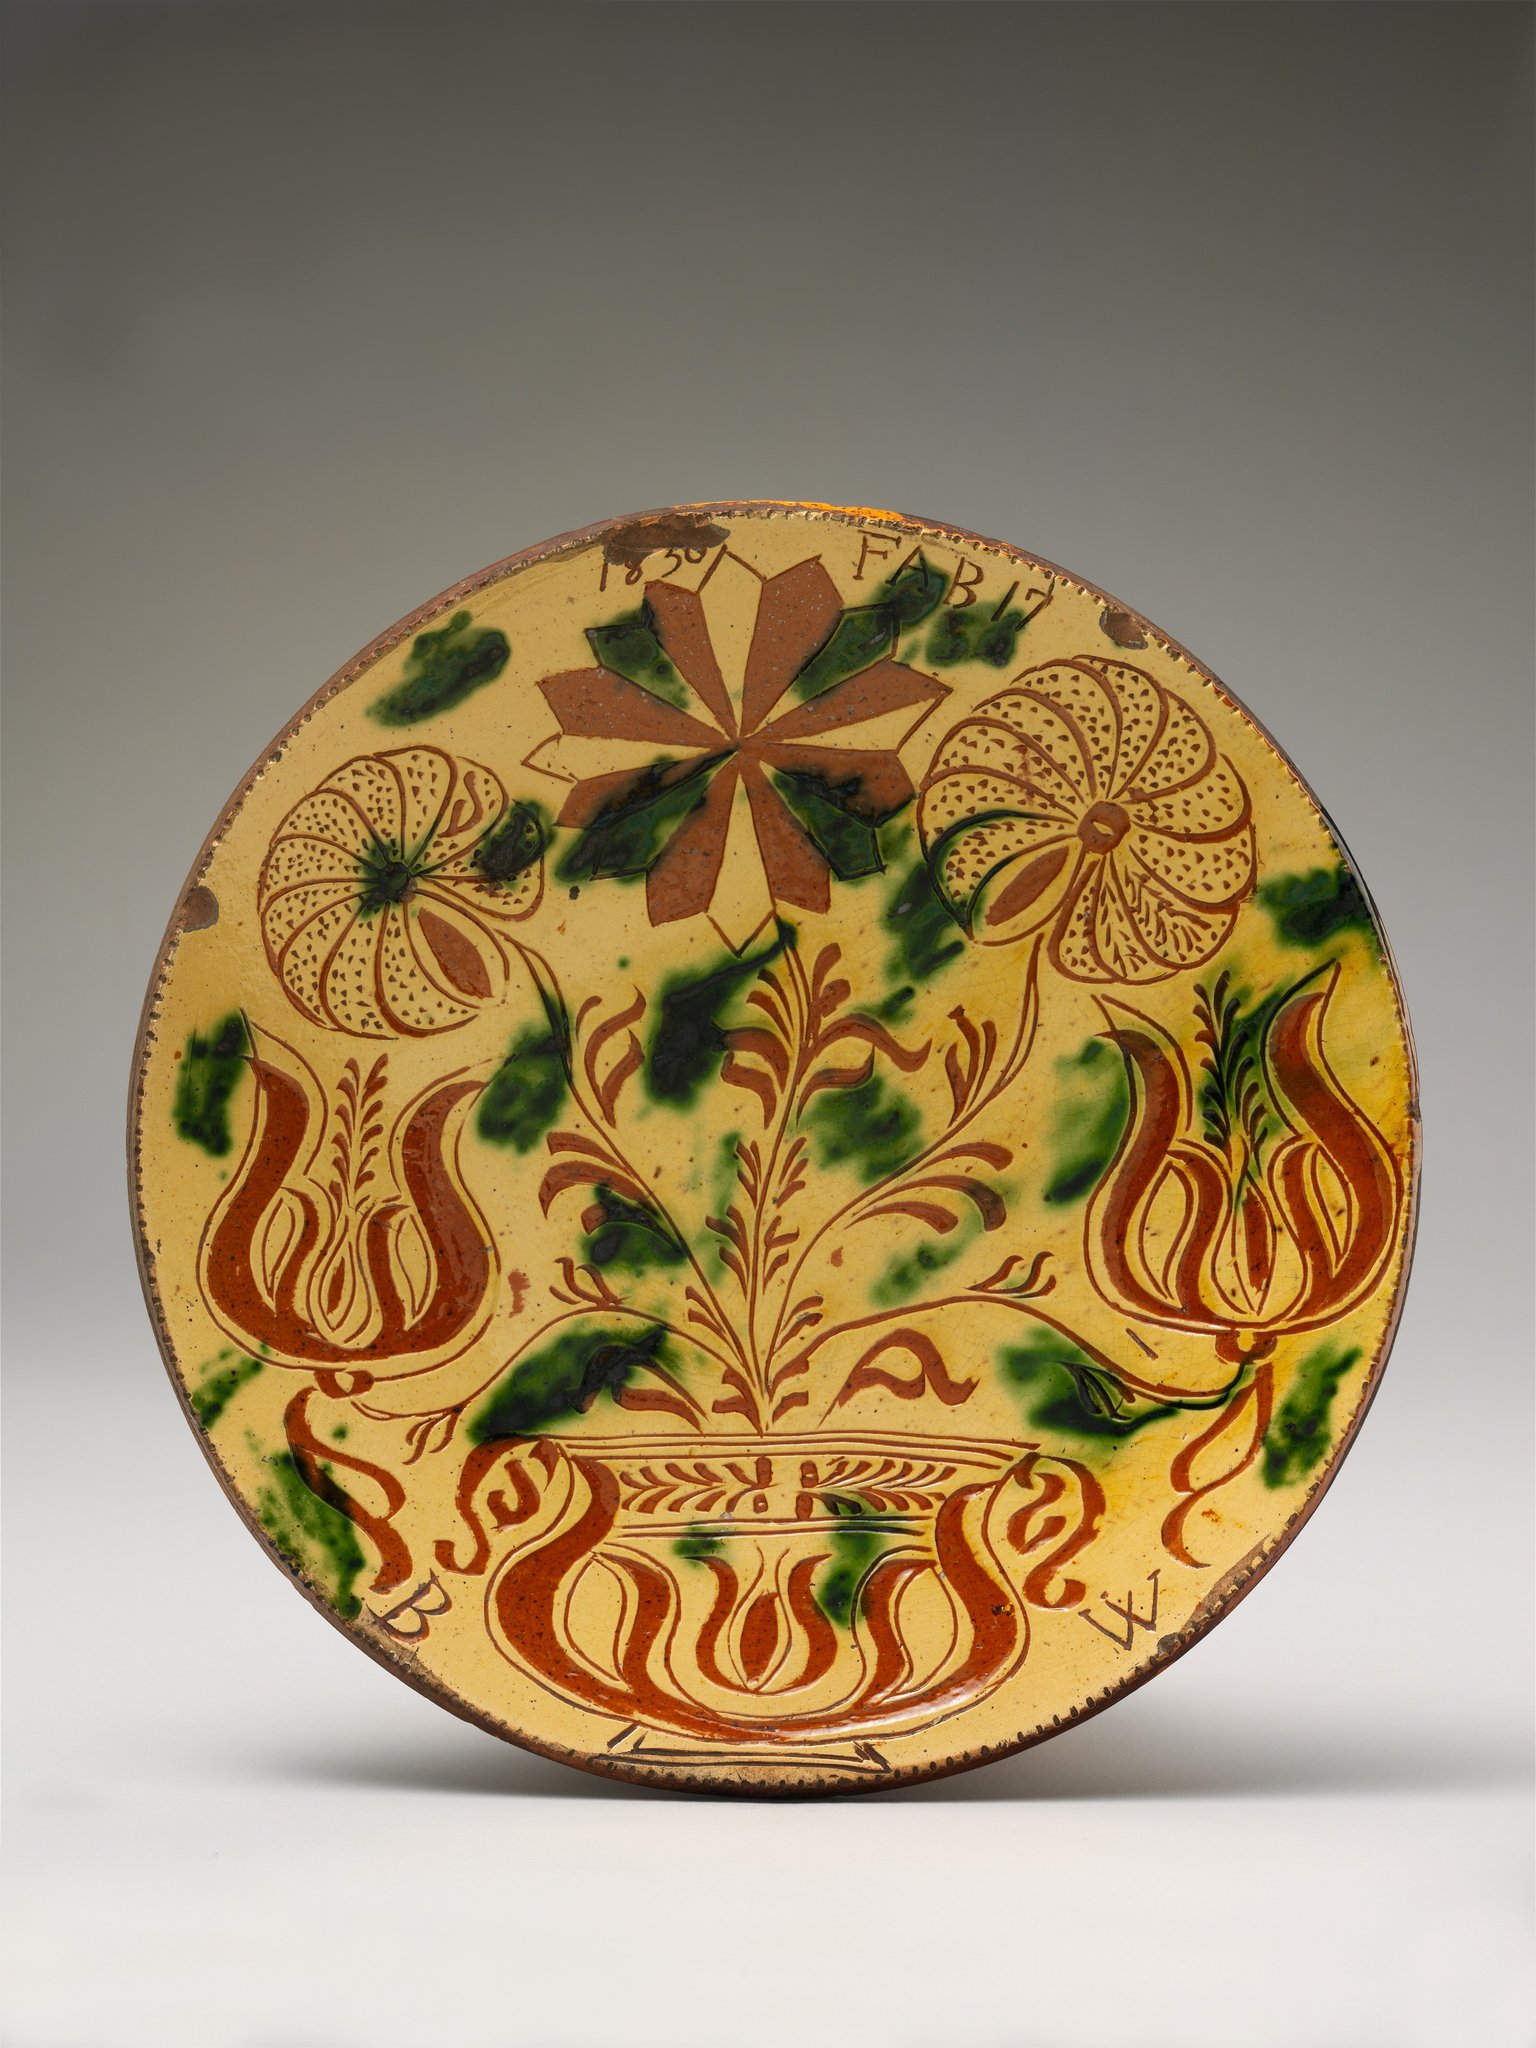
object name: plate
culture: american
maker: john monday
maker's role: artist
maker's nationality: american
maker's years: 1809-1862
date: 1830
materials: earthenware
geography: united states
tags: flowers